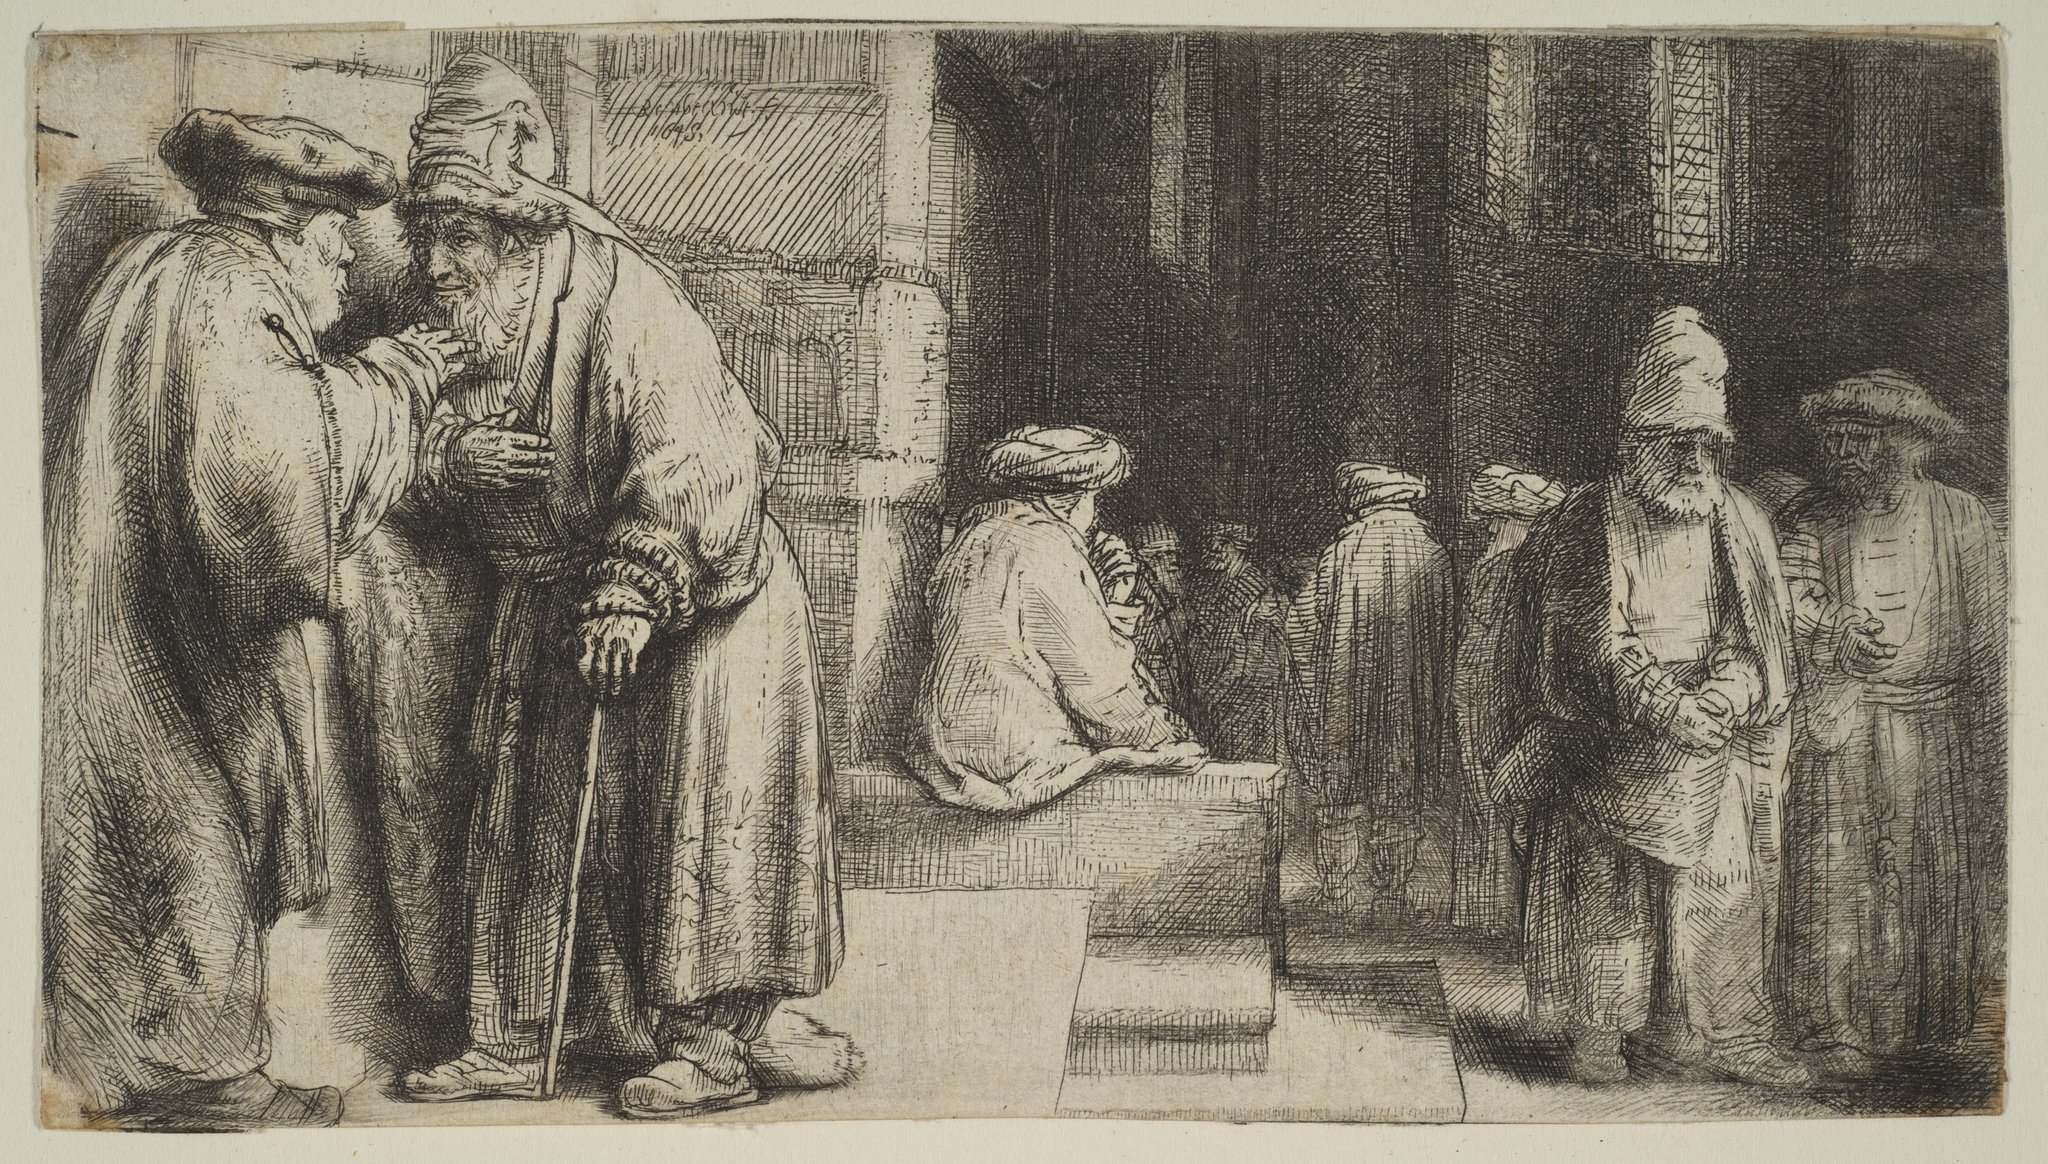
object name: print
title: Jews in a Synagogue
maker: rembrandt van rijn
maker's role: artist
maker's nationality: dutch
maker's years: 1606-1669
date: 1648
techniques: drypoint, etching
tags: synagogues,men